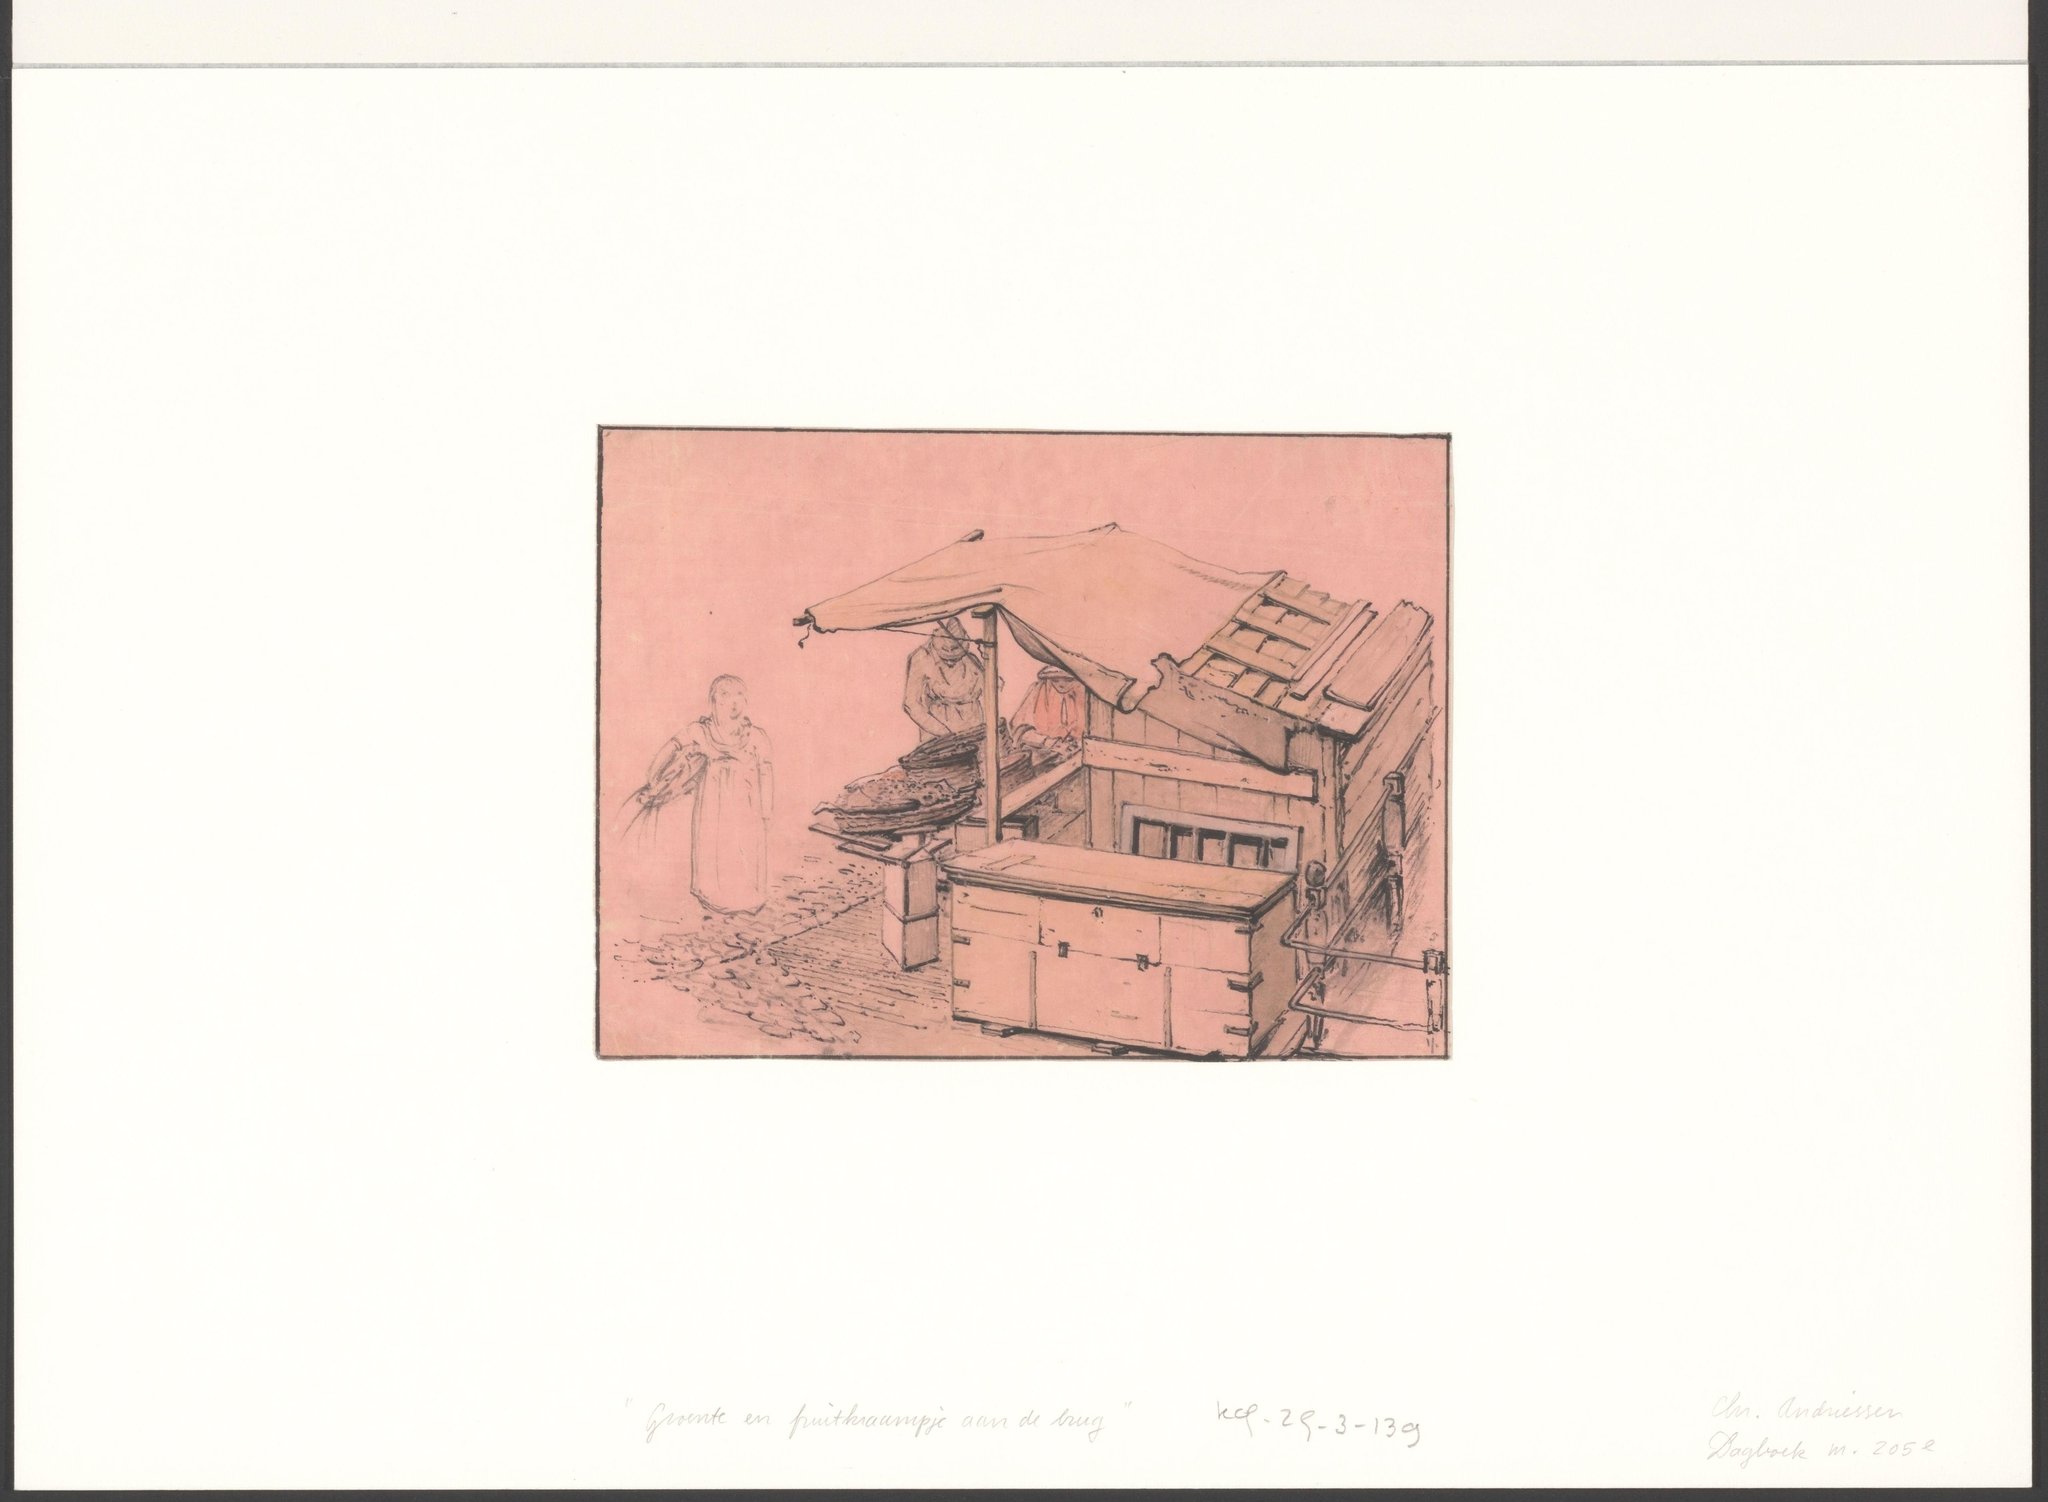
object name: print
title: Groente- en fruitkraam aan de brug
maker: christiaan andriessen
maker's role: draughtsman, print maker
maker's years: 1775-1846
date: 1805-1808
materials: ink, paper, watercolor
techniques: brush, pen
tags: vegetables, market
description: Dagboekblad uit het getekende dagboek dat Christiaan Andriessen bijhield van 1805 tot en met 1808.